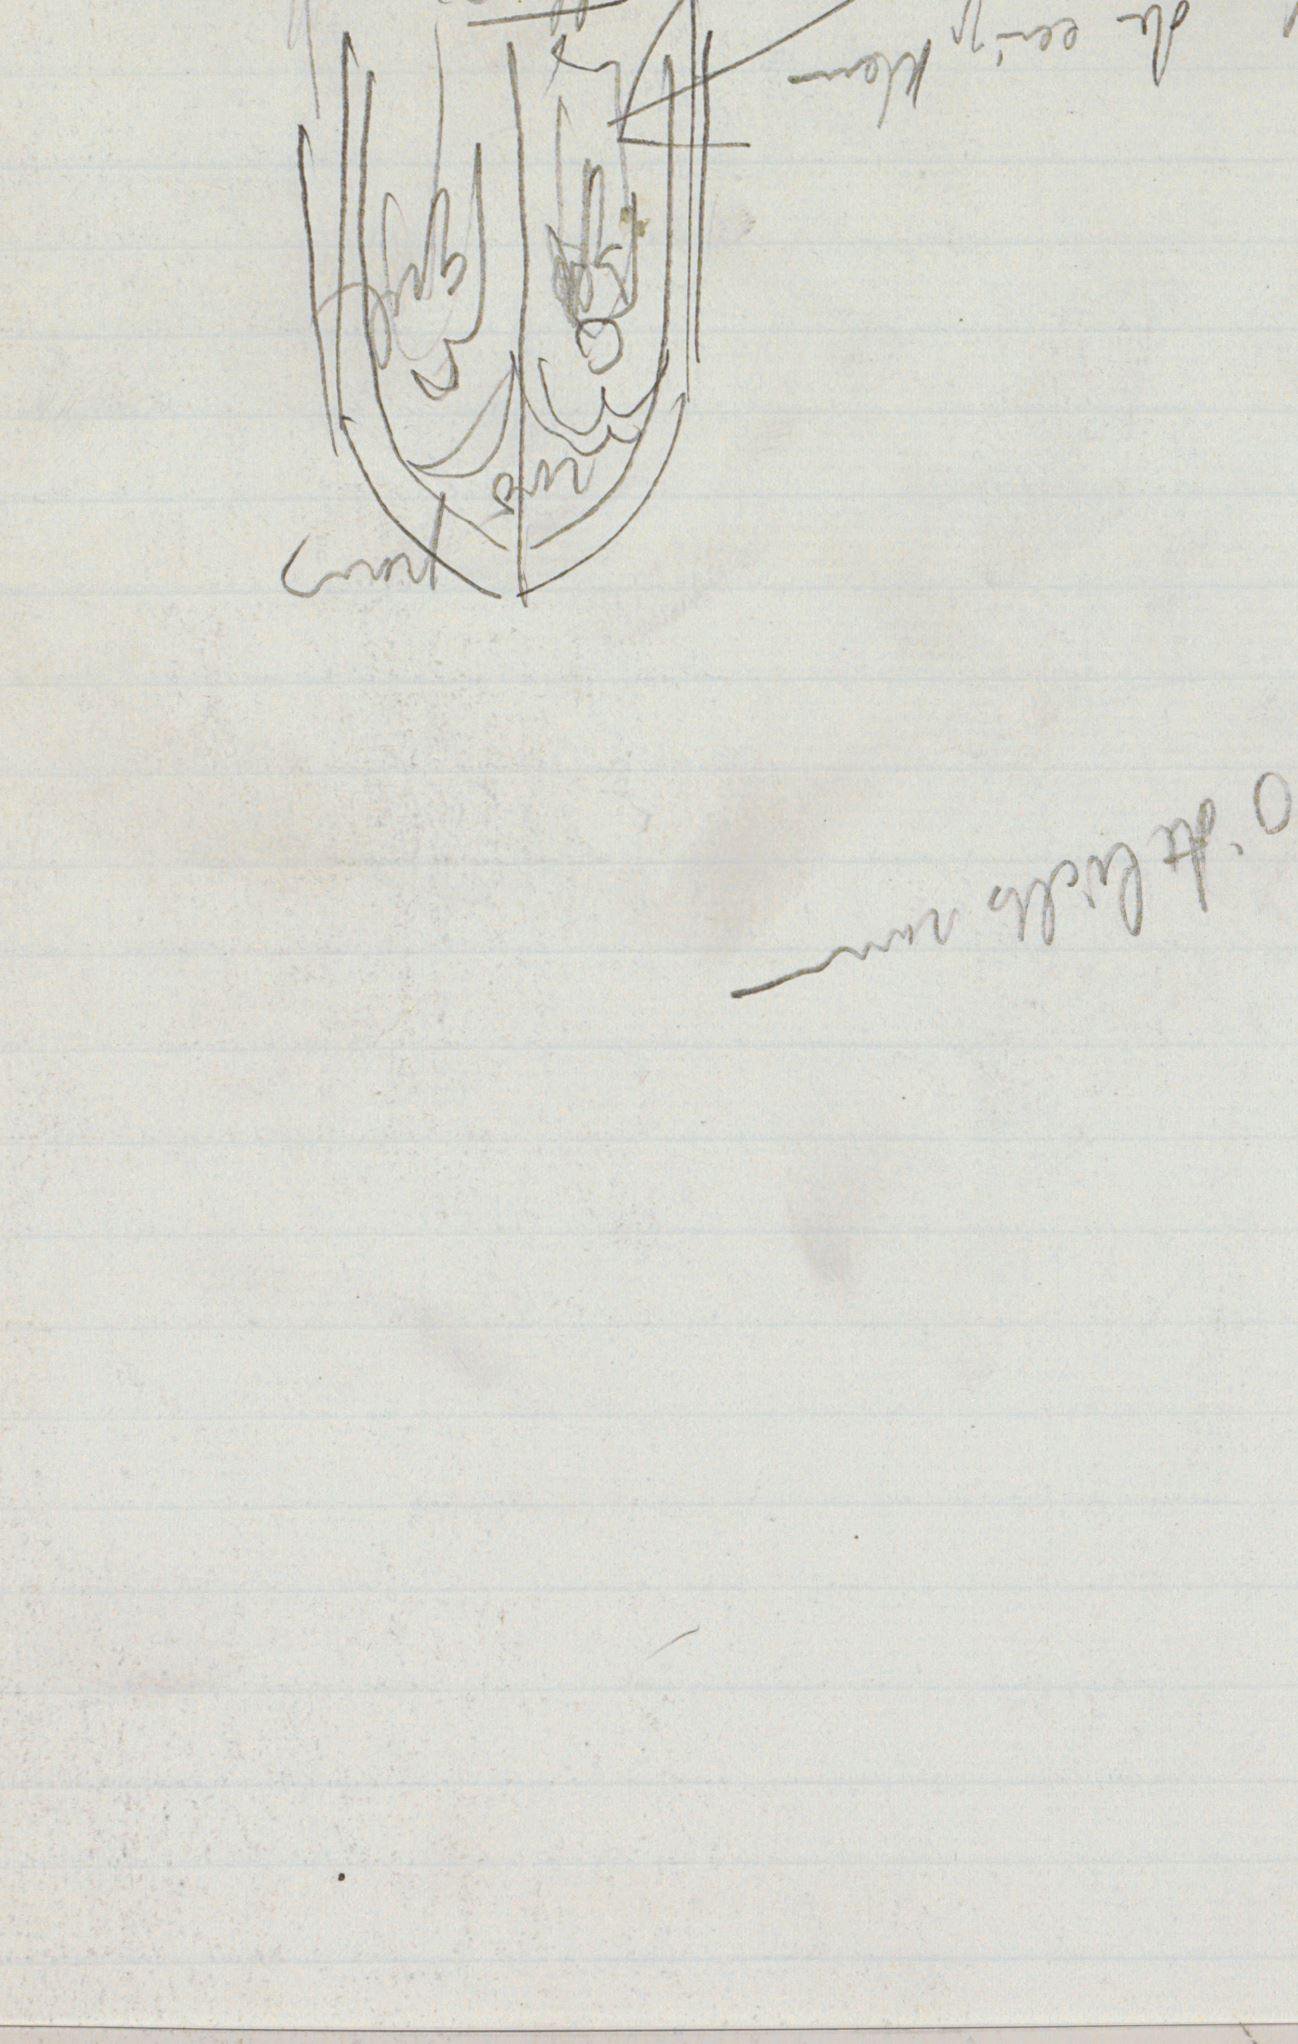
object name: sketchbook leaf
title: Kerkraam met glas-in-lood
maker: marius bauer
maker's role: draughtsman, print maker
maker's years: 1867-1932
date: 1877-1932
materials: pencil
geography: paris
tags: church-window, e.g. rose-window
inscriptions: annotation: ‘O [...] lichts raam/ de eenige kleur’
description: Pagina 39 uit een schetsboek met 68 bladen.